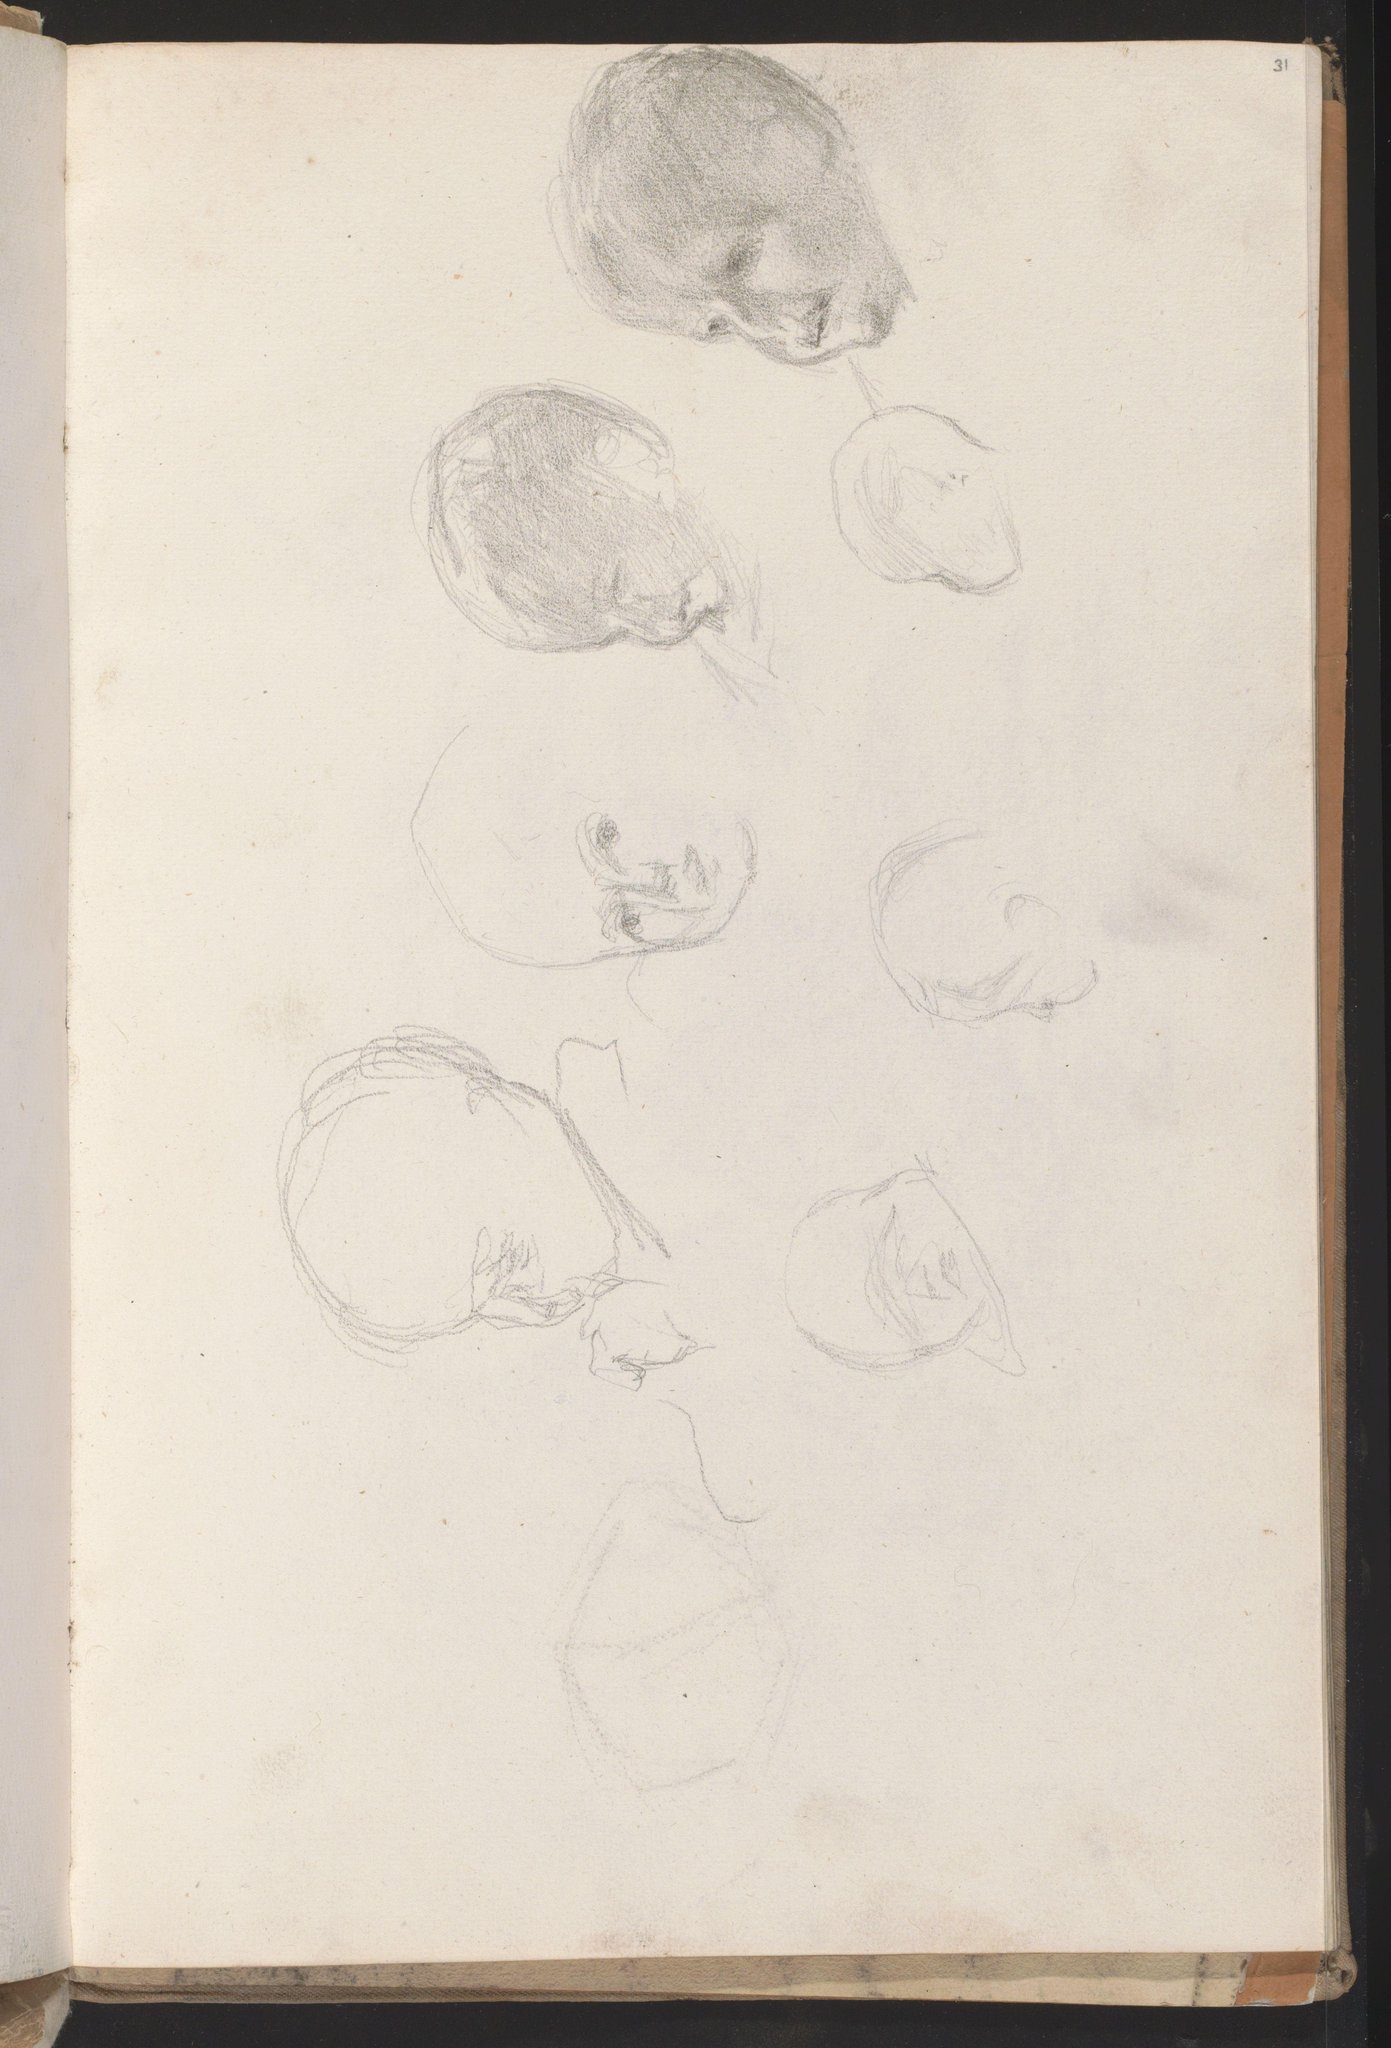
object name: sketchbook leaf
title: Kinderkoppen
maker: albert neuhuys (1844-1914)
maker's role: draughtsman, painter, print maker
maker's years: 1844-1914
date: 1854-1914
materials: paper, pencil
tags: head (human), infant, baby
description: Blad 31 recto uit een schetsboek met 53 bladen.